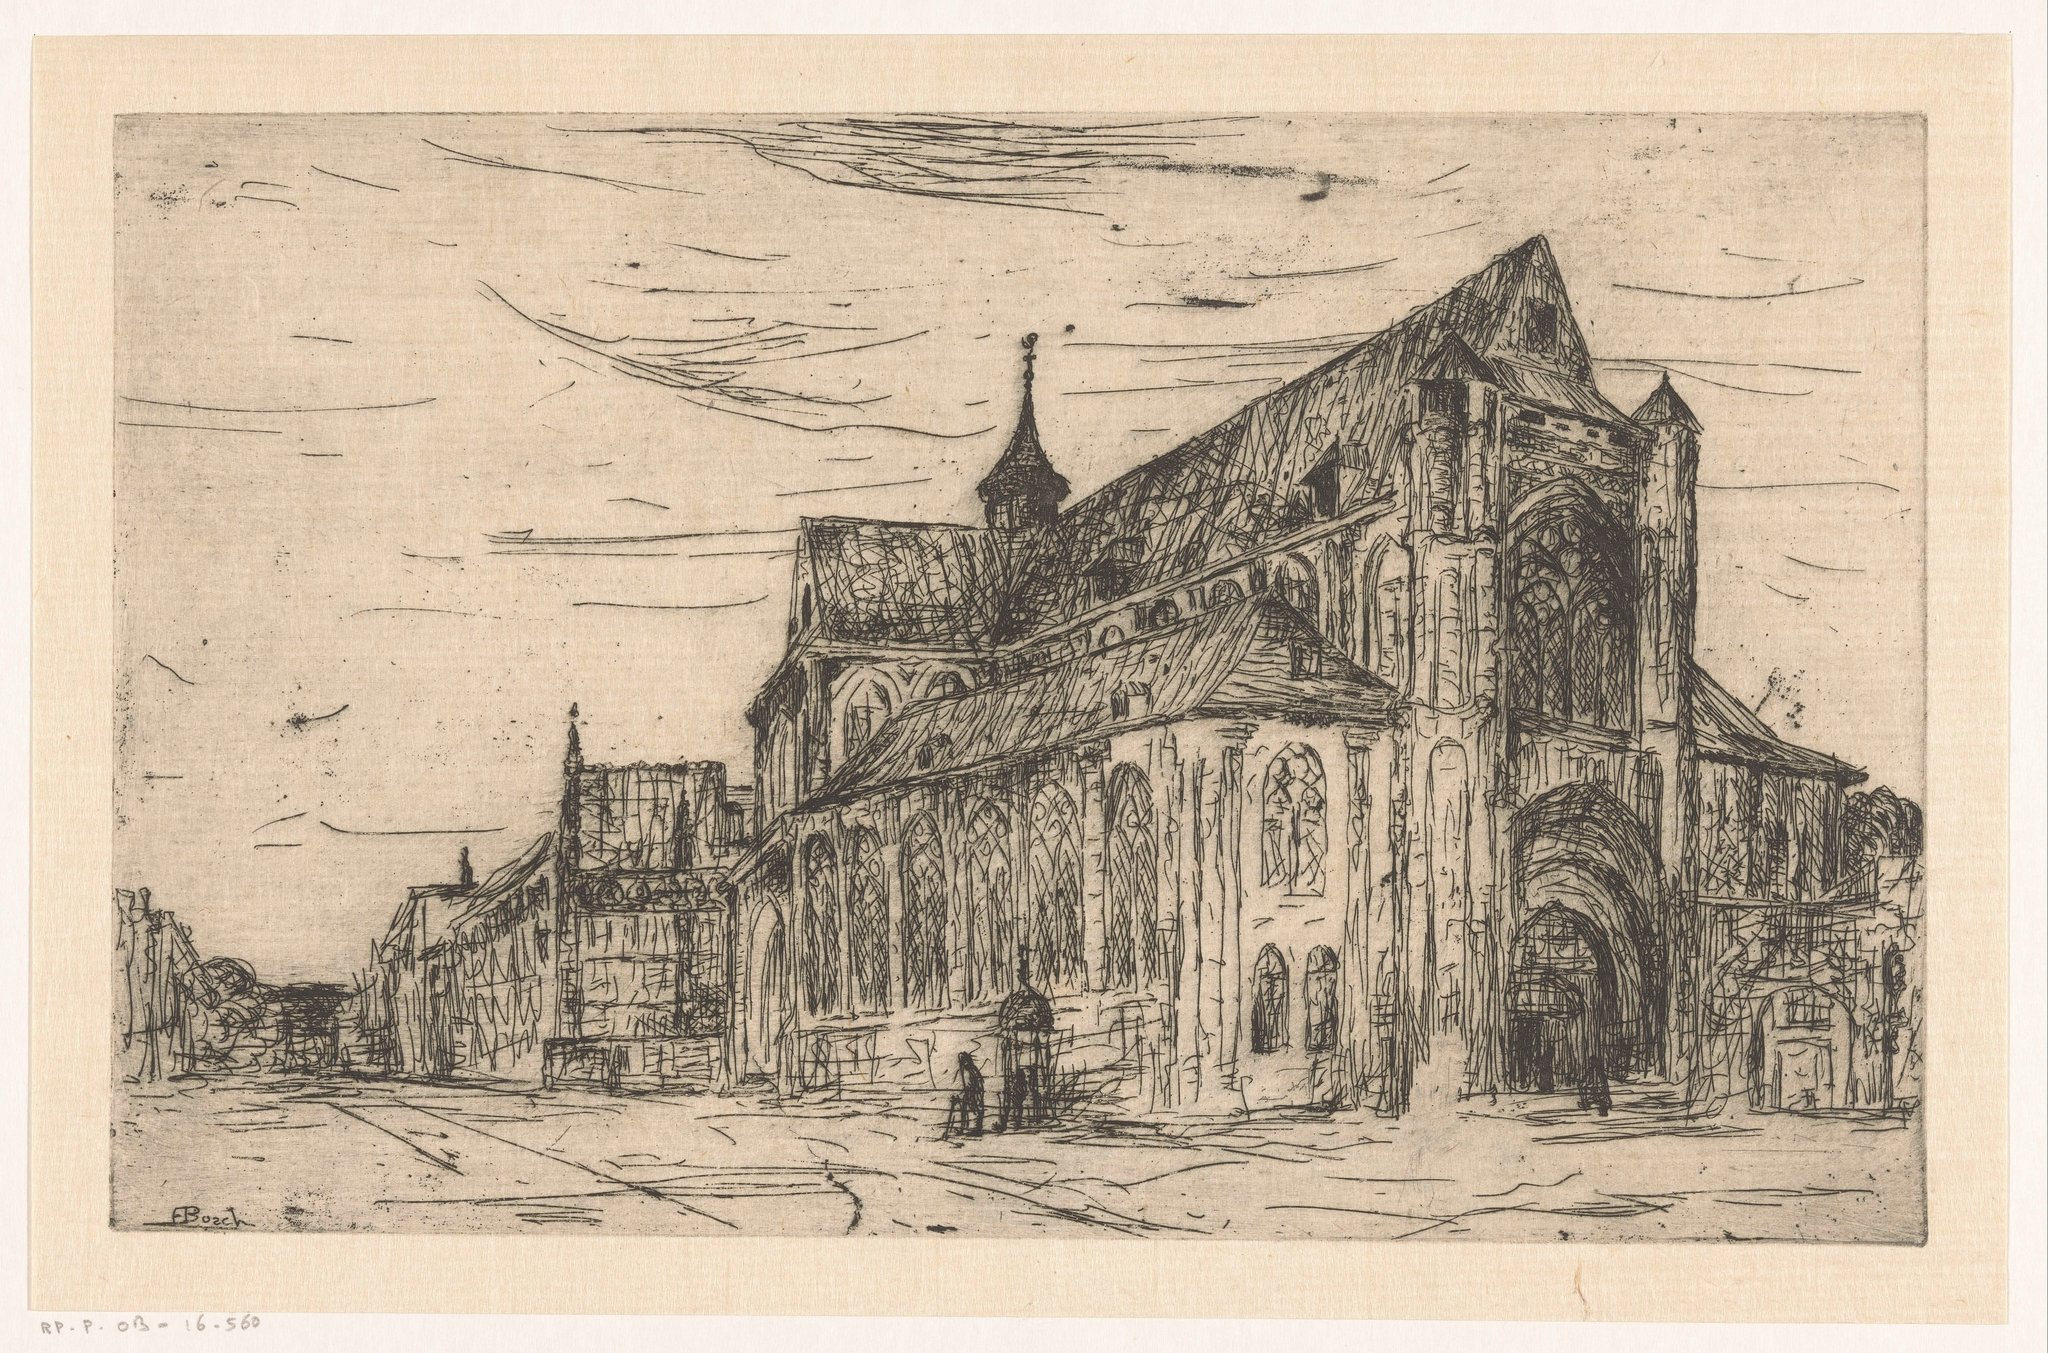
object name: print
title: Gezicht op een kerk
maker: etienne bosch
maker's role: print maker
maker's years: 1863-1933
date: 1873-1892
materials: paper, ink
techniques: drypoint, etching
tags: church (exterior)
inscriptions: inscription: ‘EBosch. Nederlandsche Etsclub 1892 no. 3’, collector's mark: Lugt 2228, signature: ‘EBosch’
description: Gezicht op een gotische kerk in een straat met in het midden een zittend en een staand figuur.